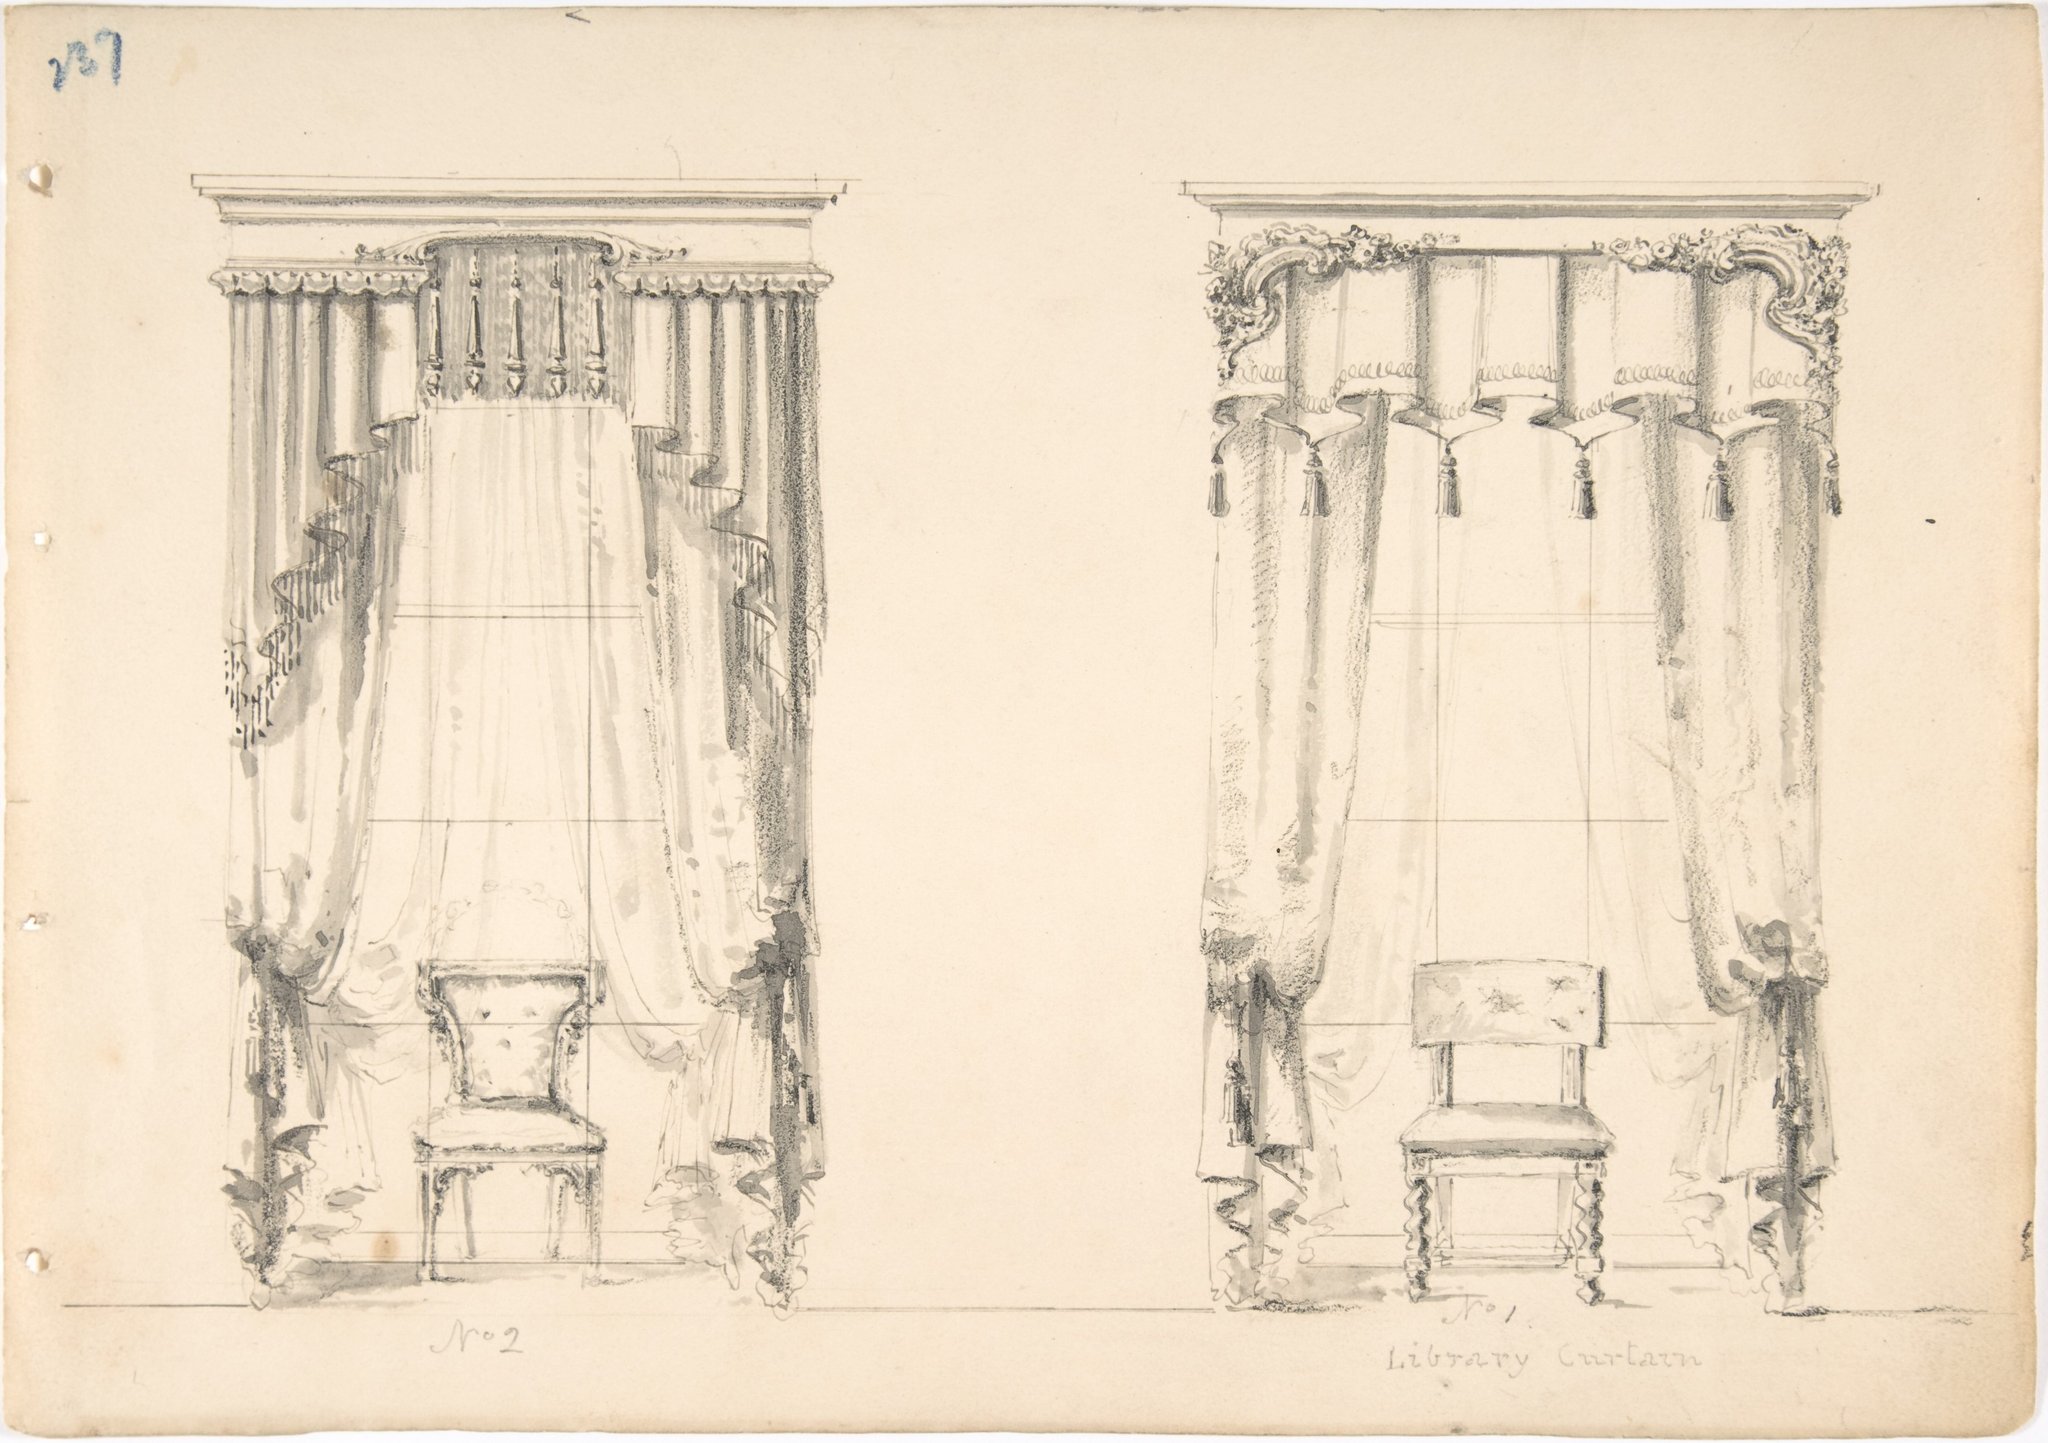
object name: drawing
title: Design for Two Tasseled Curtains, Shown with Chairs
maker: anonymous, british, 19th century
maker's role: artist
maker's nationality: british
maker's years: 1800-1900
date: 1801-1833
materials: ink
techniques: brush, pen, wash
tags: windows,curtains,chairs